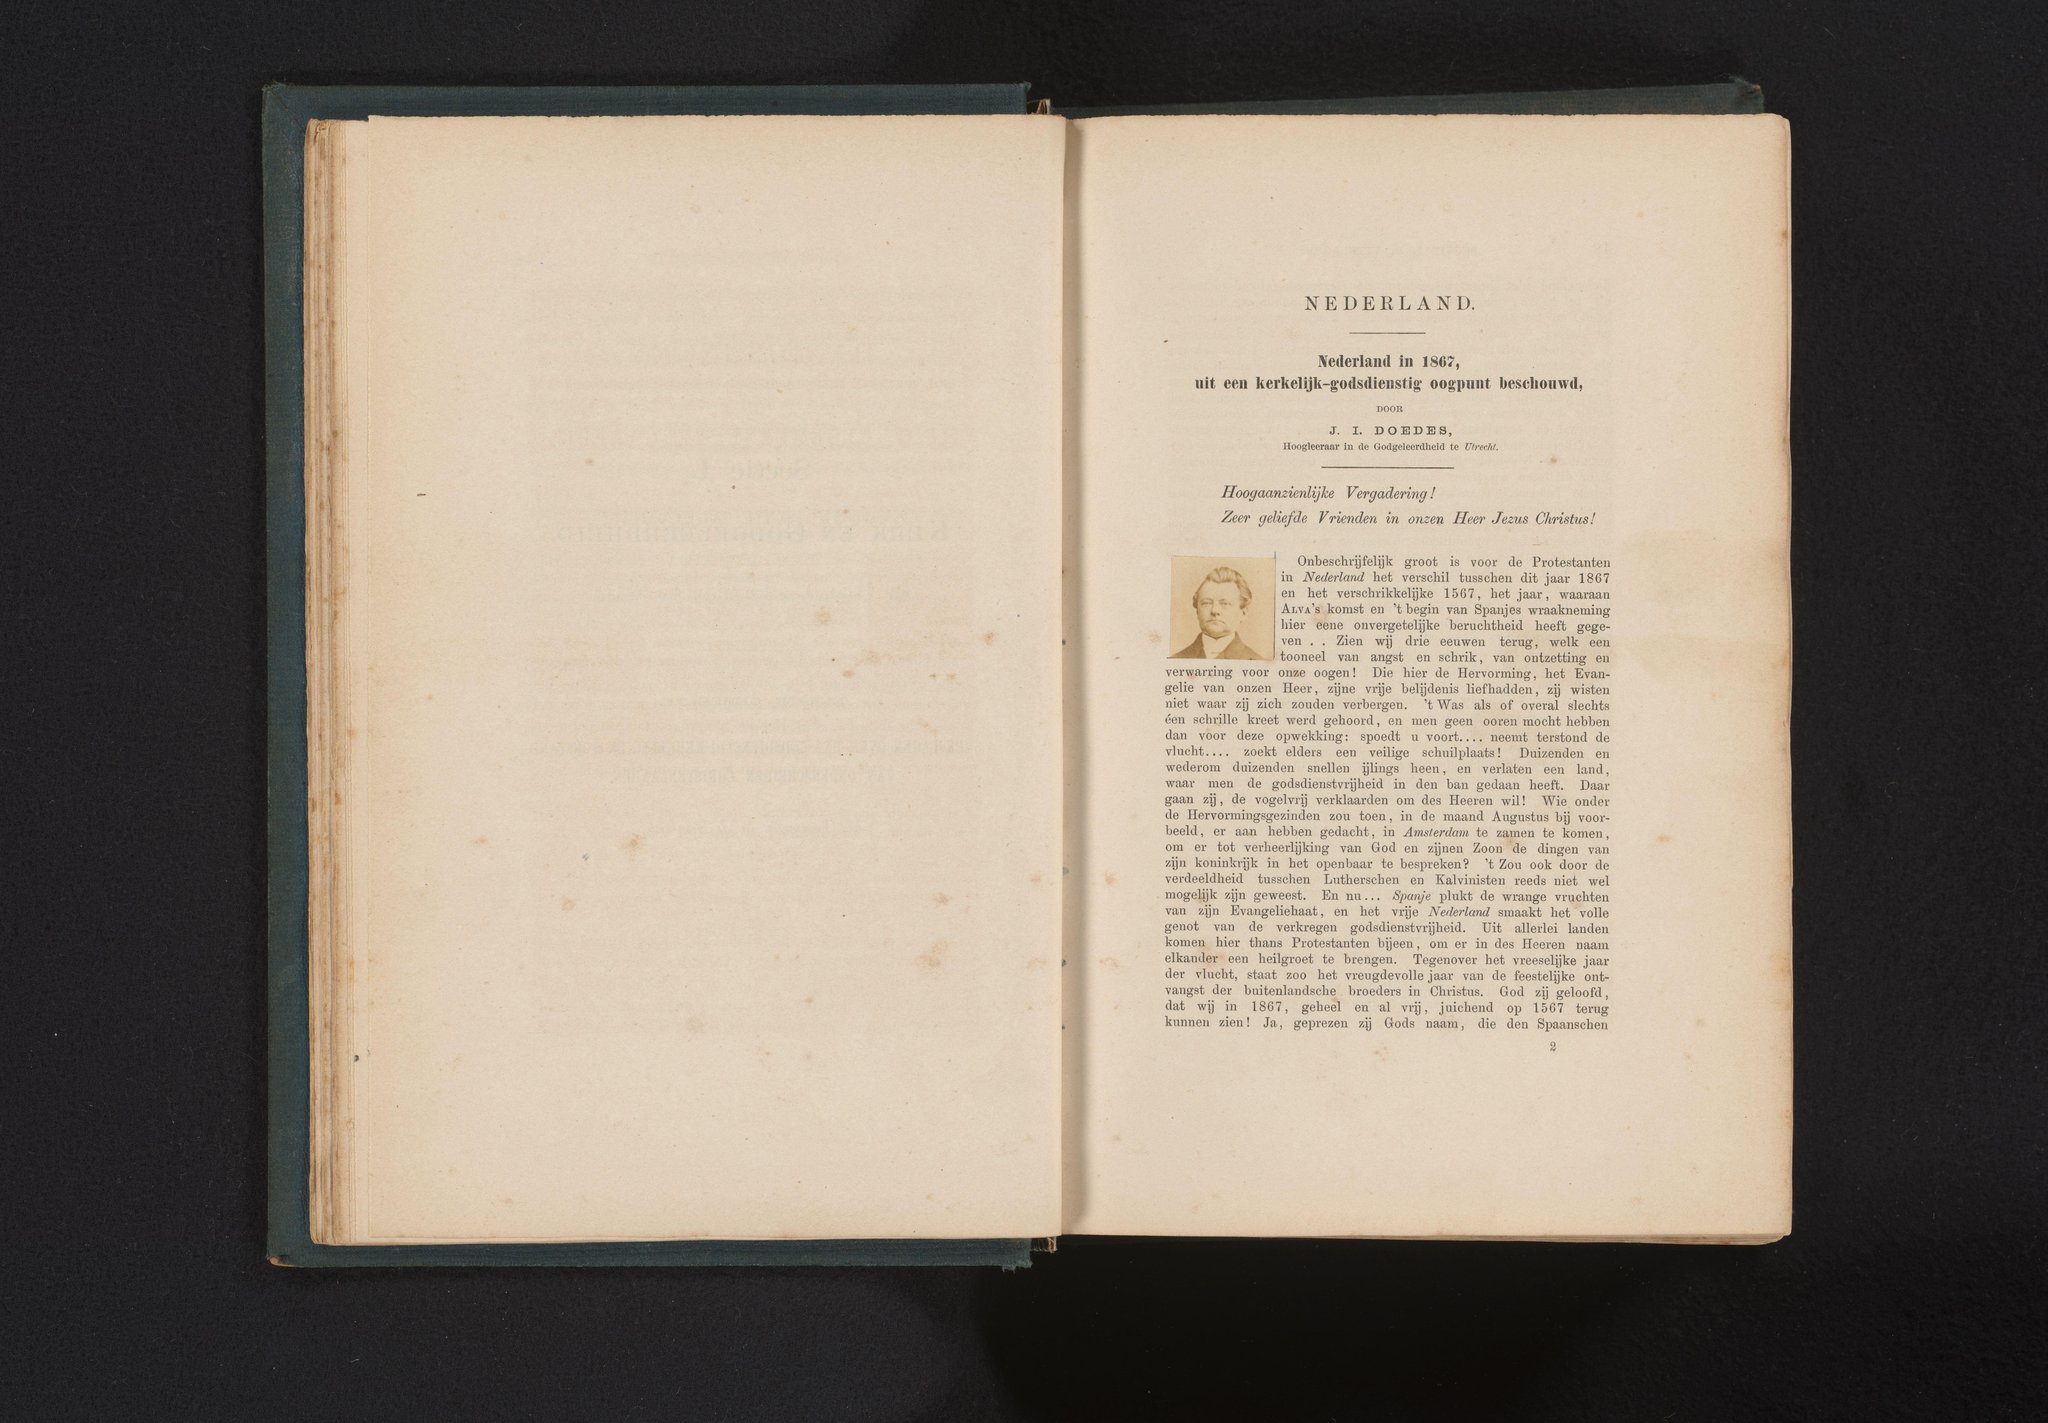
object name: page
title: Portret van professor Jacob Isaac Doedes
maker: Anonymous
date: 1855-1867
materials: paper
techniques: albumen print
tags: langerak, utrecht, historical persons, professor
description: Foto op ongenummerde pagina voor pagina 18.